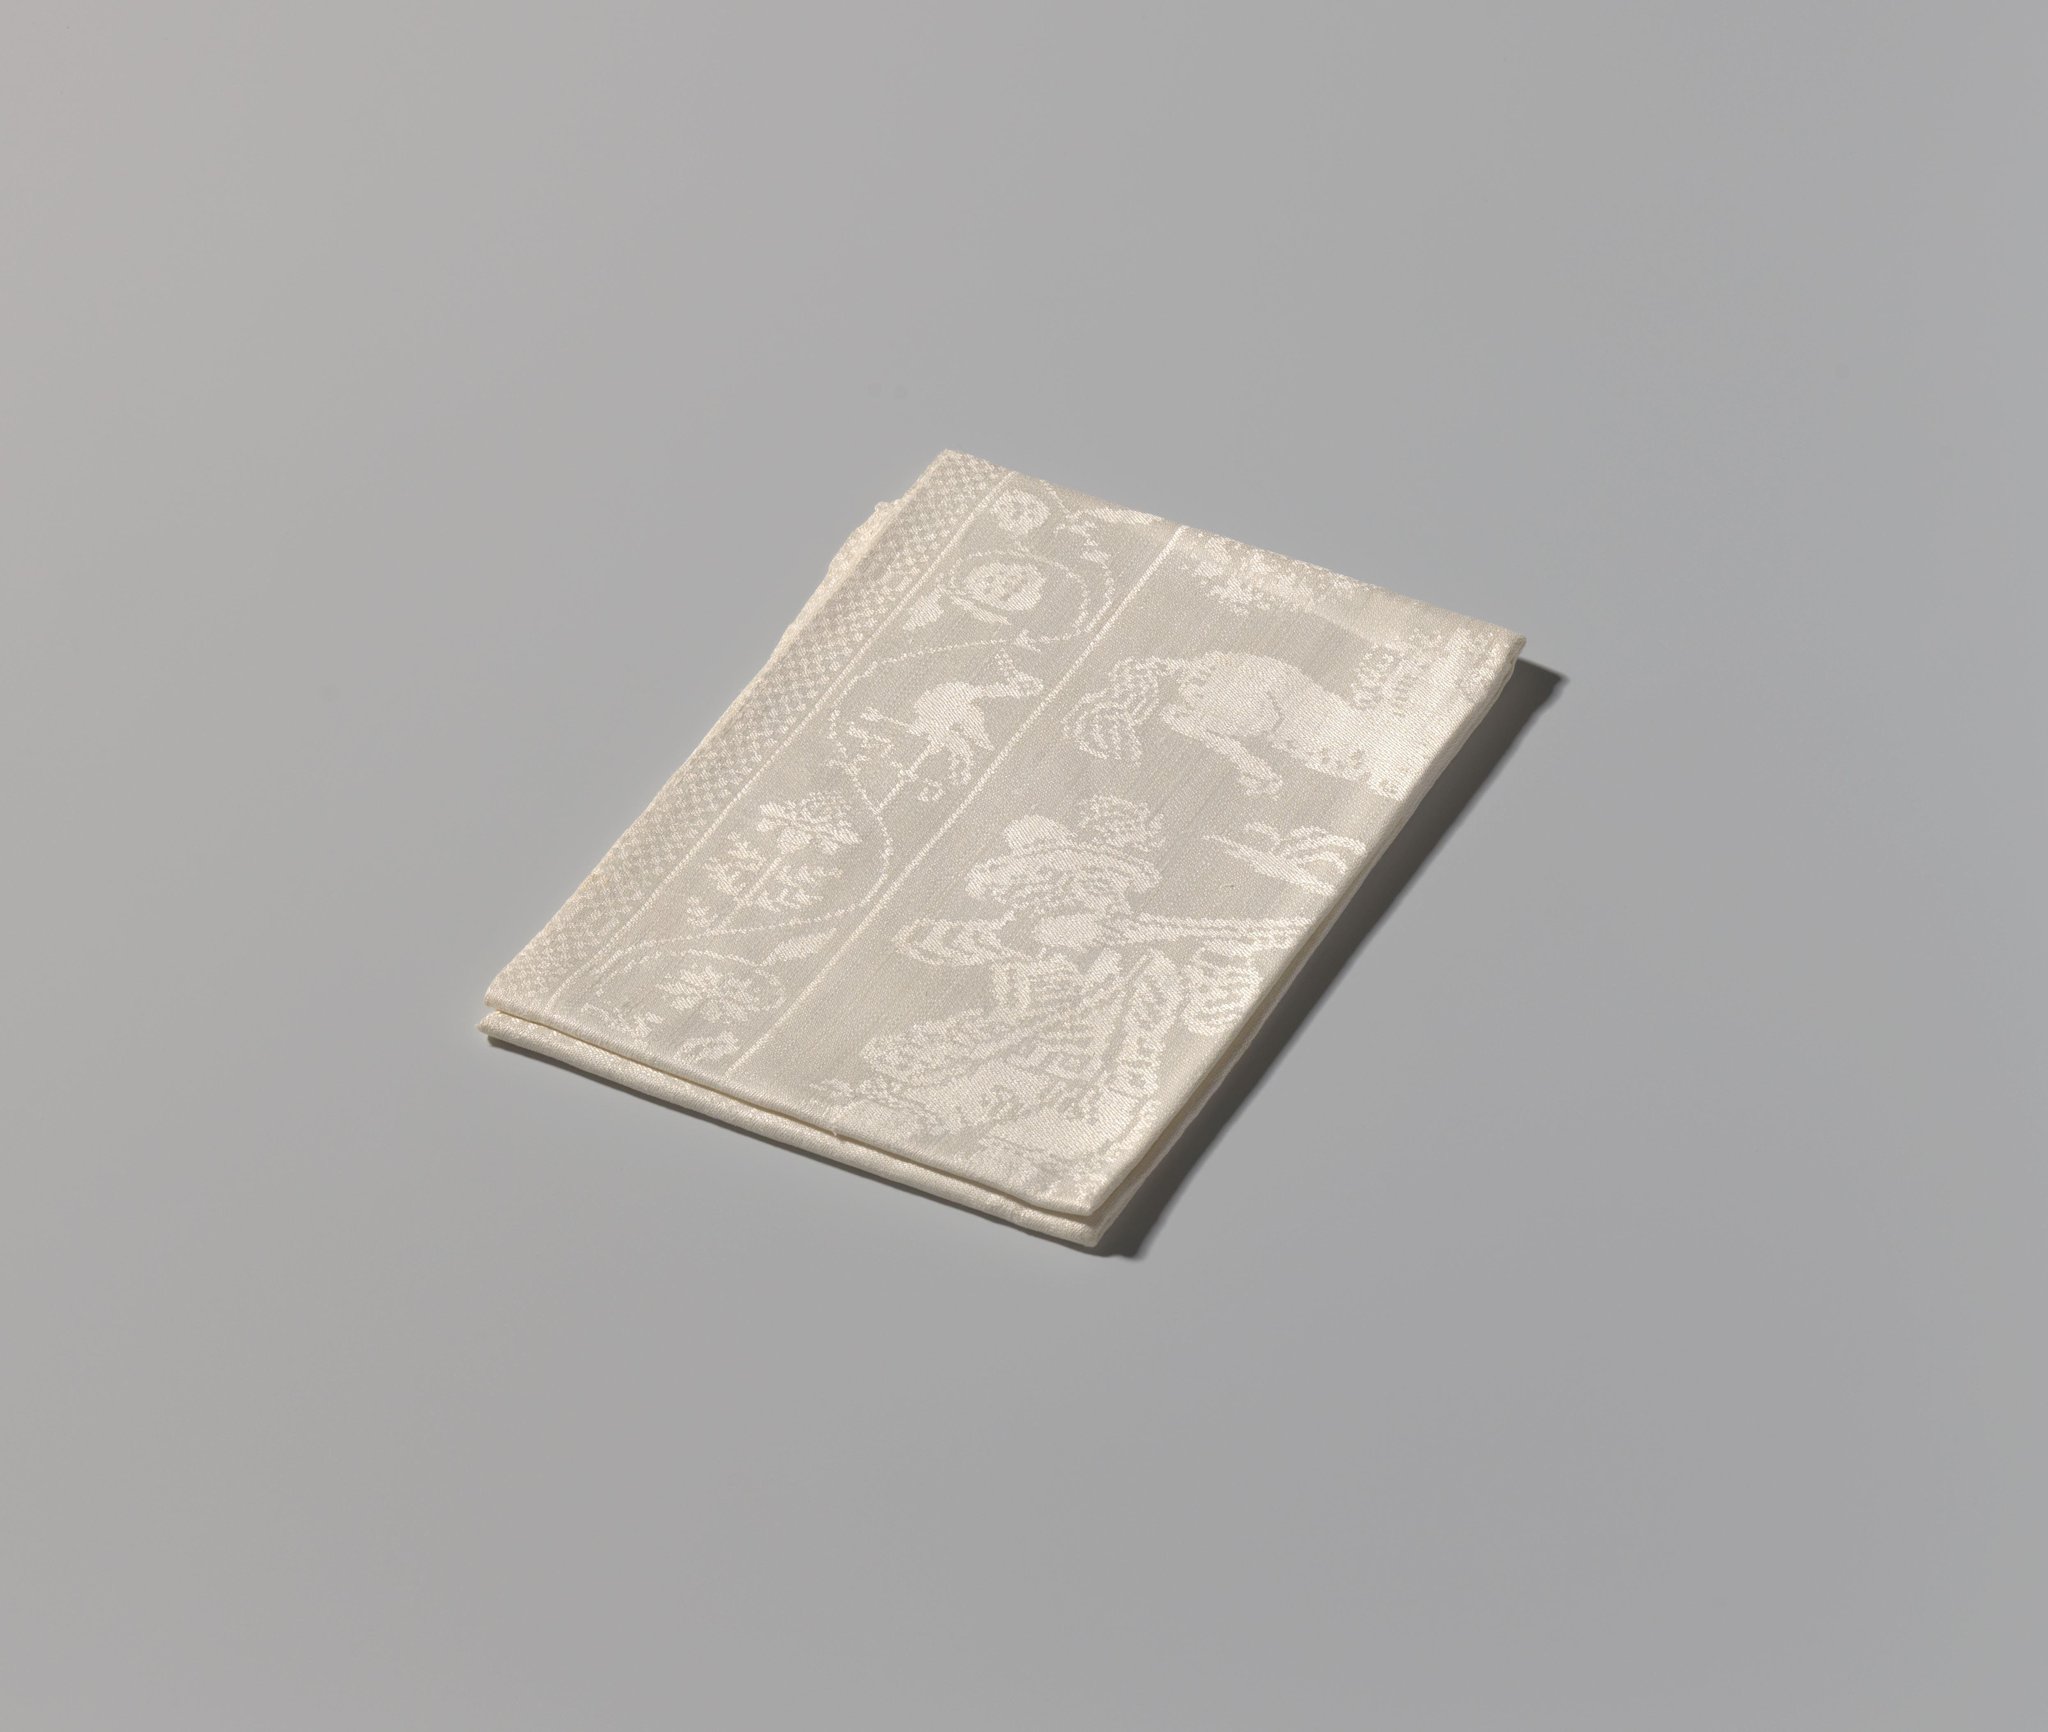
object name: napkin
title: Servet met een jachttafereel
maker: quirijn jansz. damast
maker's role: mayor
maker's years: 1580-1638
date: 1650-1699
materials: linen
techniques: damask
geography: haarlem